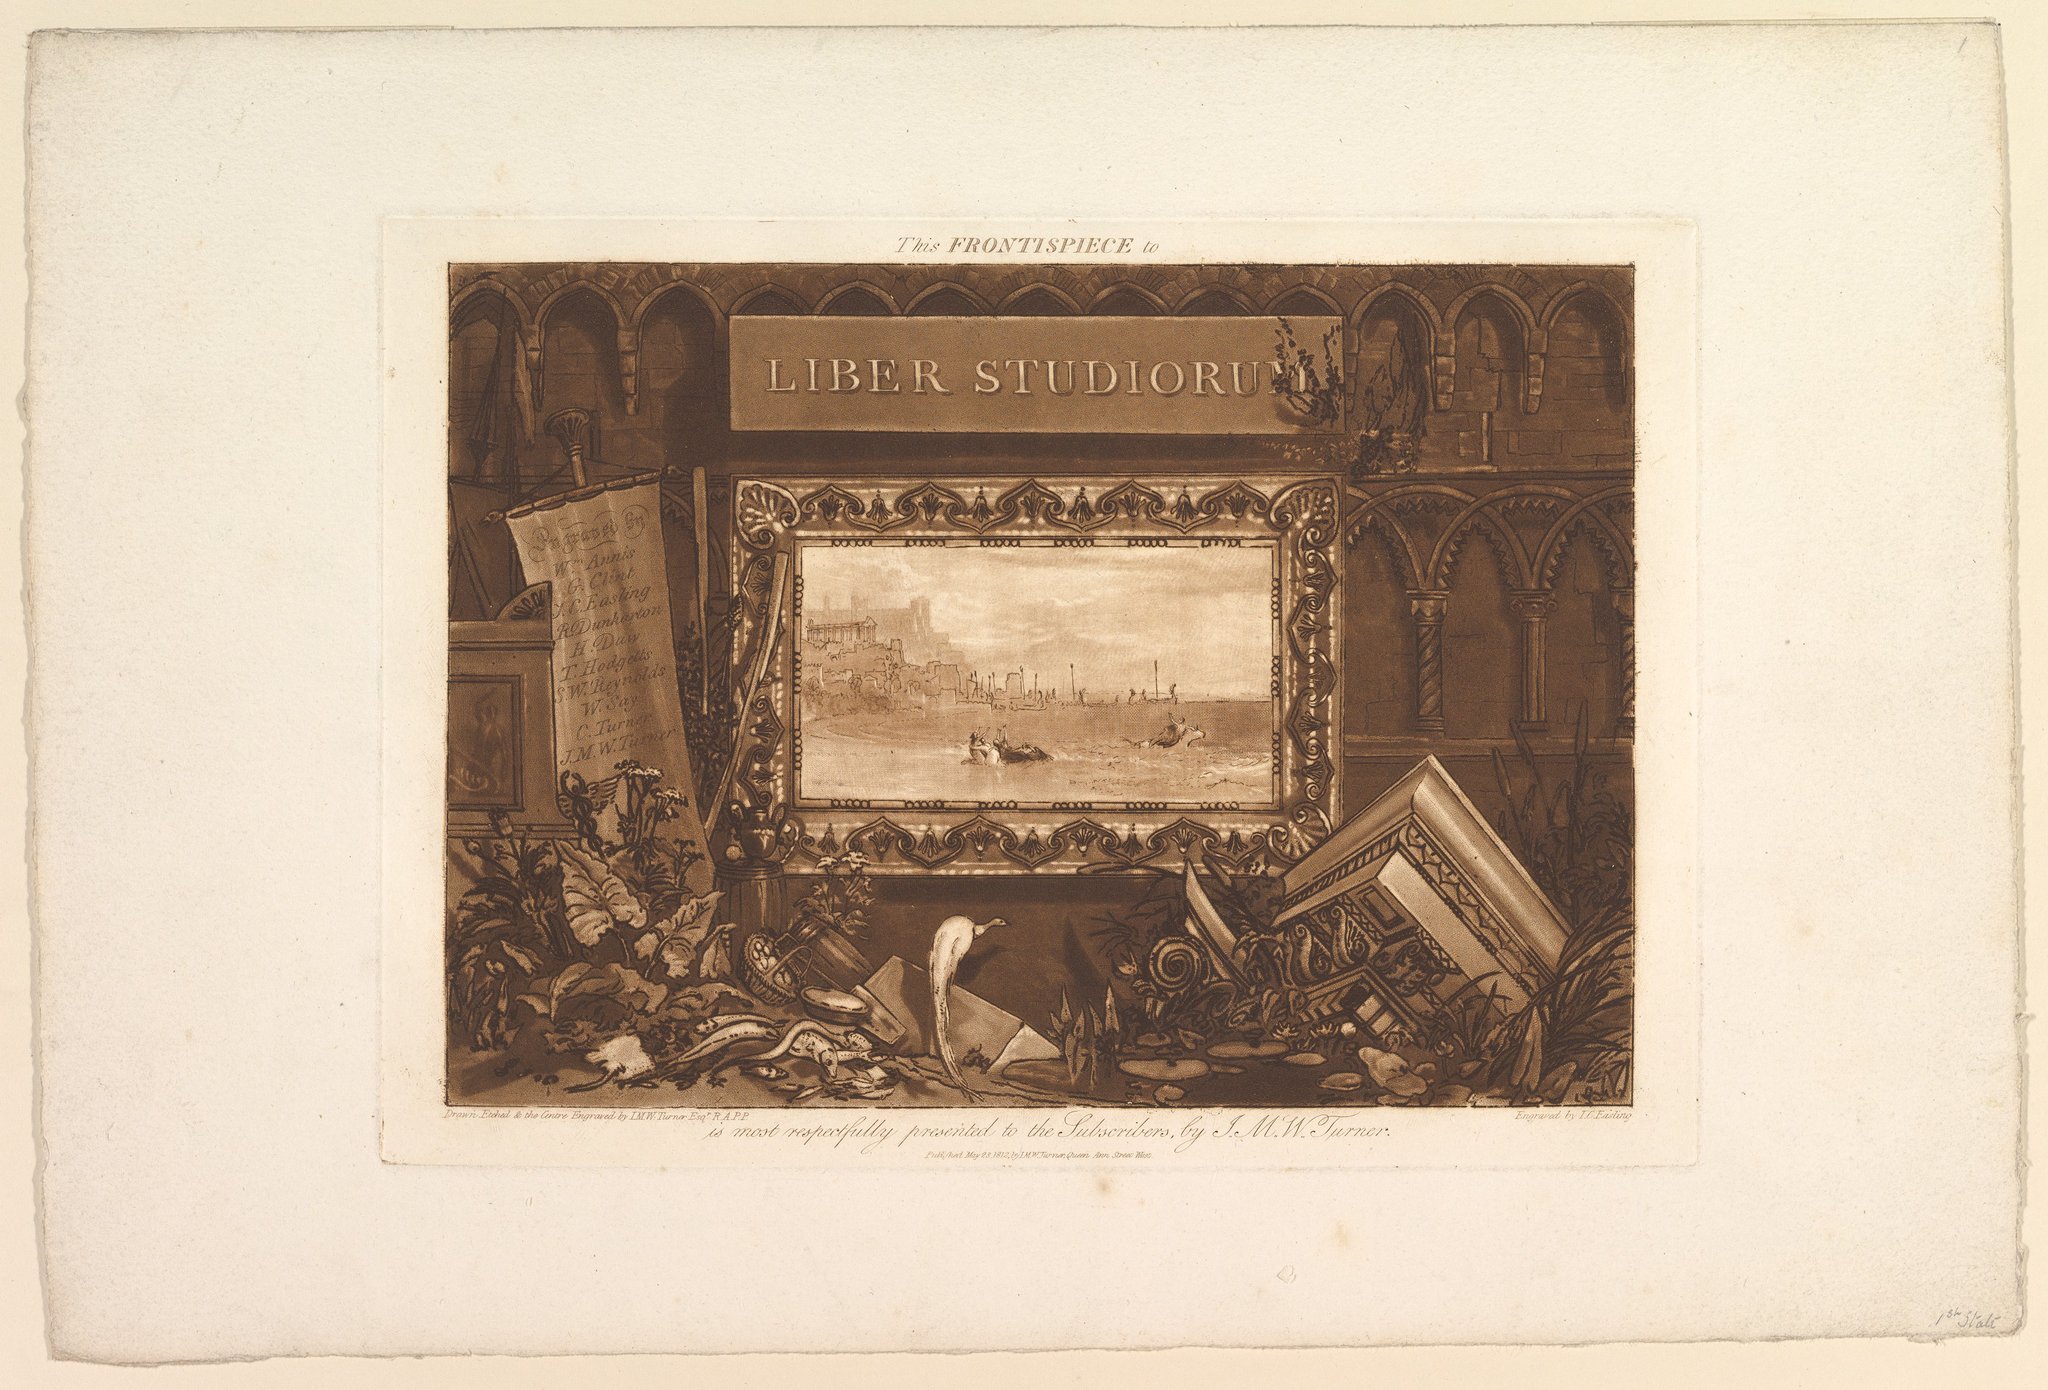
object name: print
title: Frontispiece from "Liber Studiorum"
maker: joseph mallord william turner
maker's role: artist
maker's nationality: british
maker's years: 1775-1851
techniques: etching, mezzotint